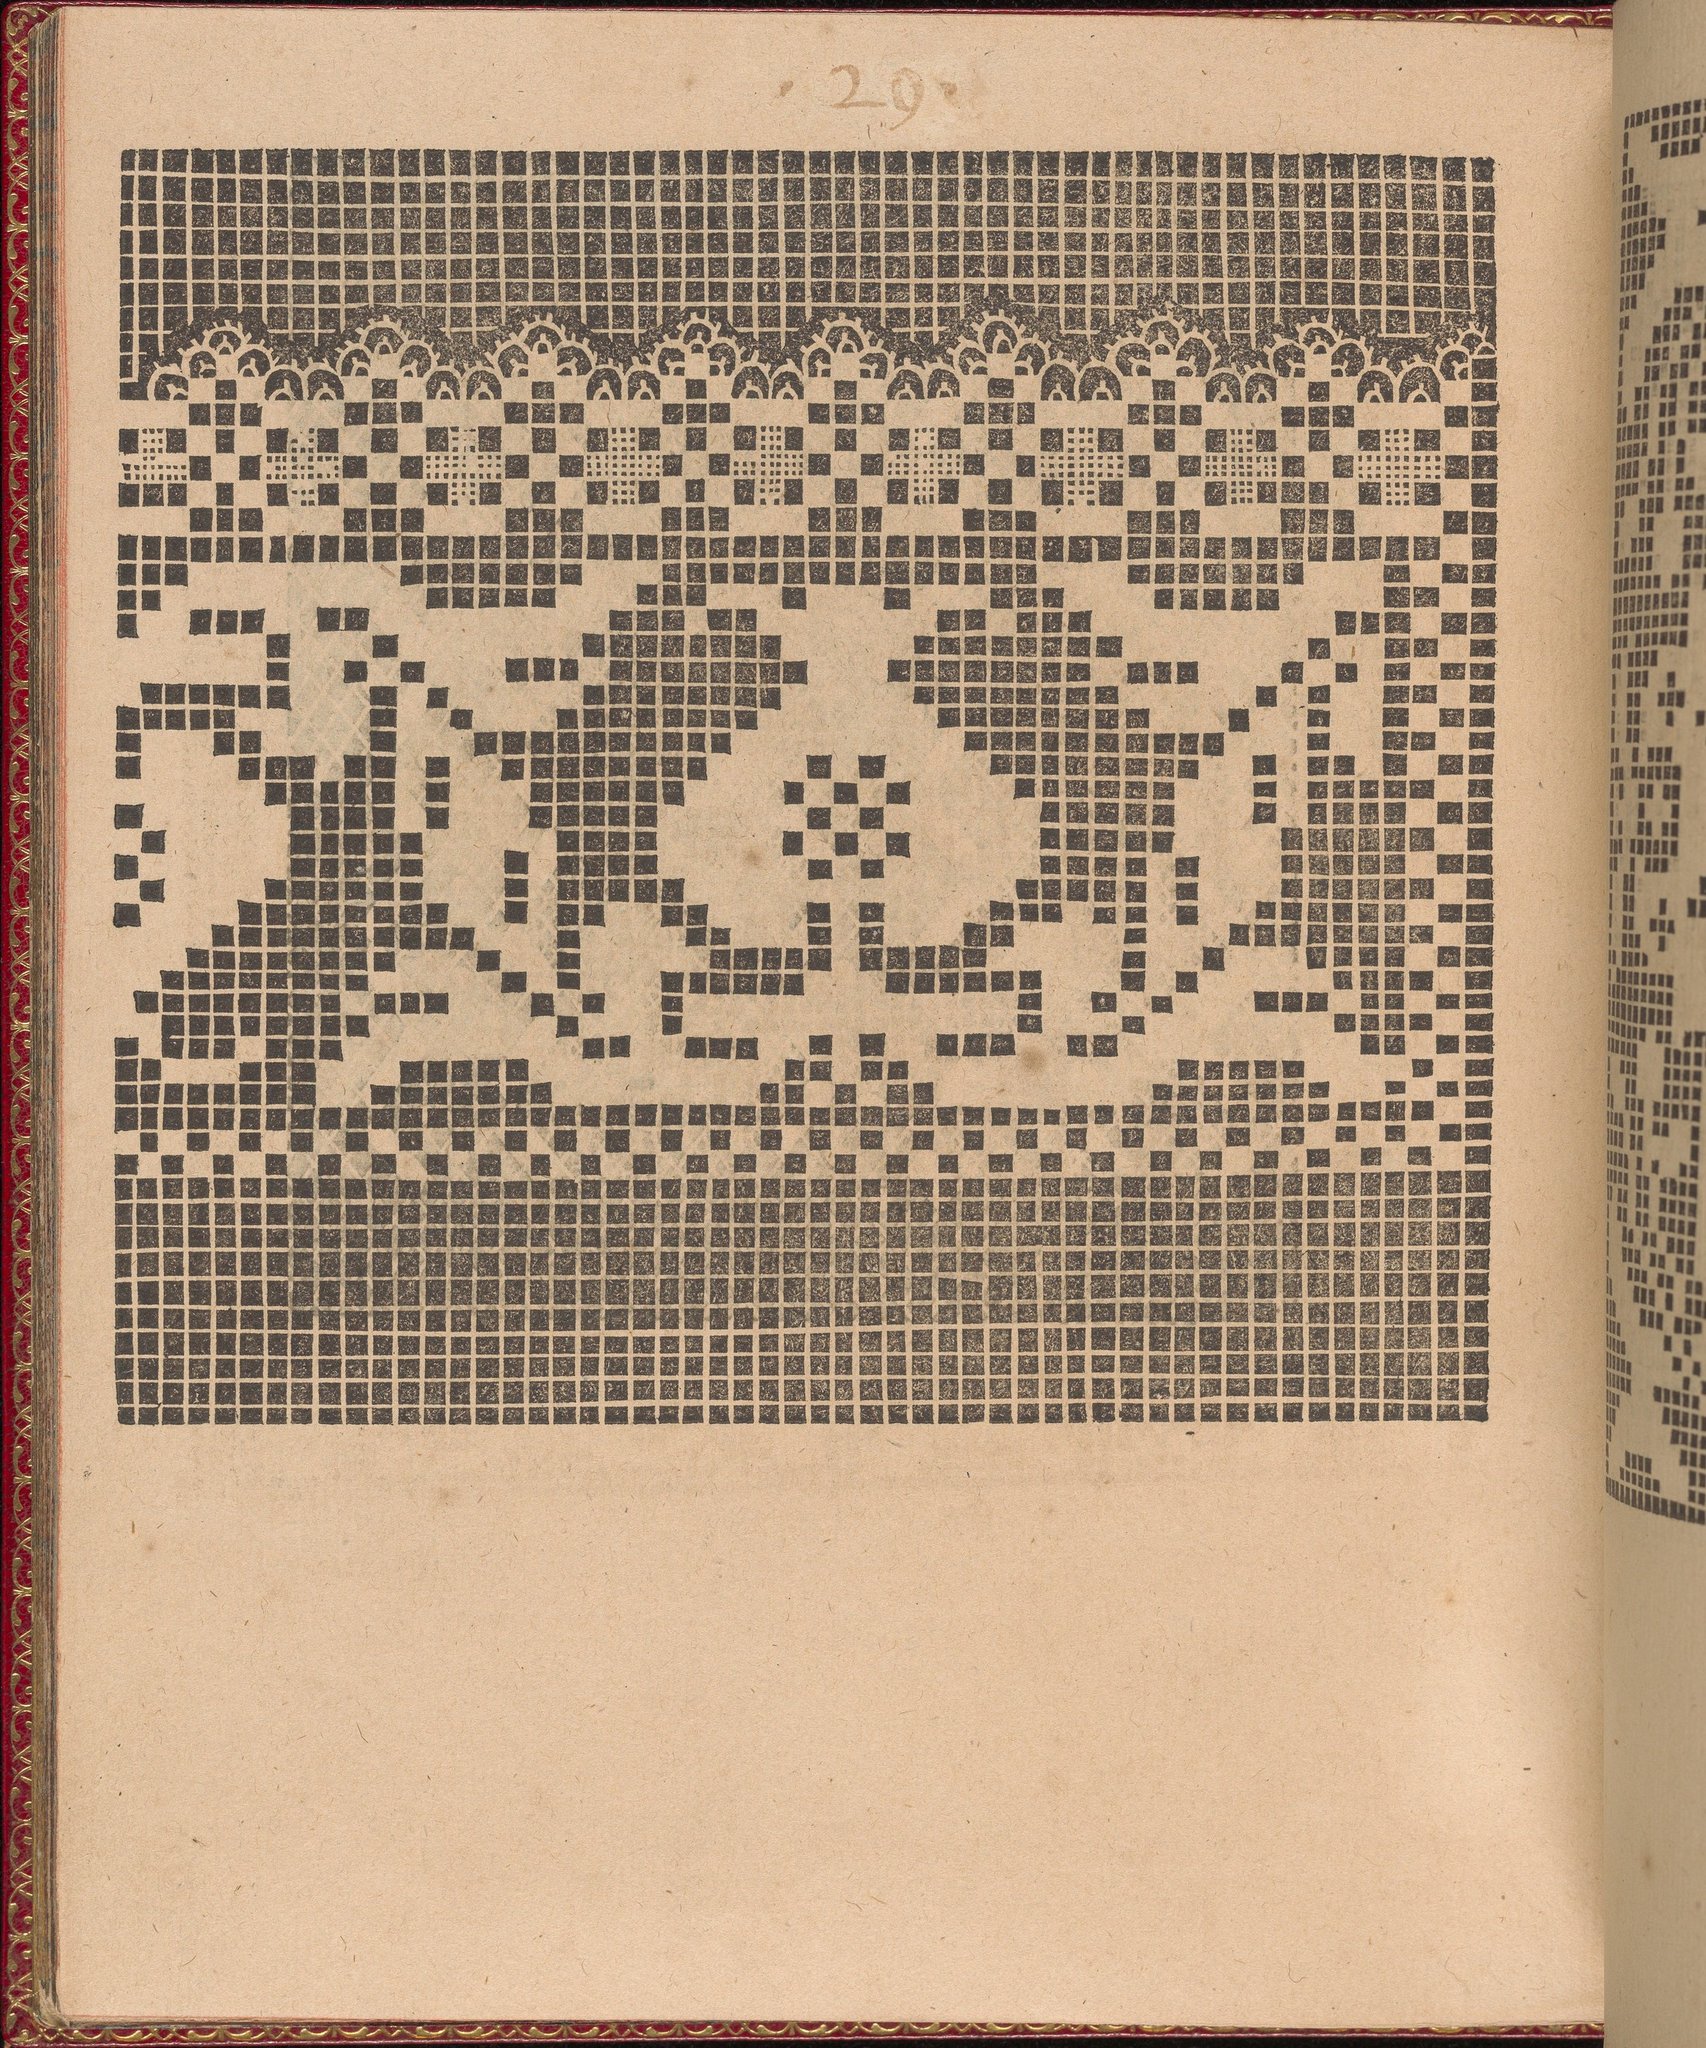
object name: book print ornament architecture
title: Les Singuliers et Nouveaux Portraicts... page 55 (verso)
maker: federico de vinciolo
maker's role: designer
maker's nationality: italian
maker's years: 1582-1599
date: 1588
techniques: woodcut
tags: ornament